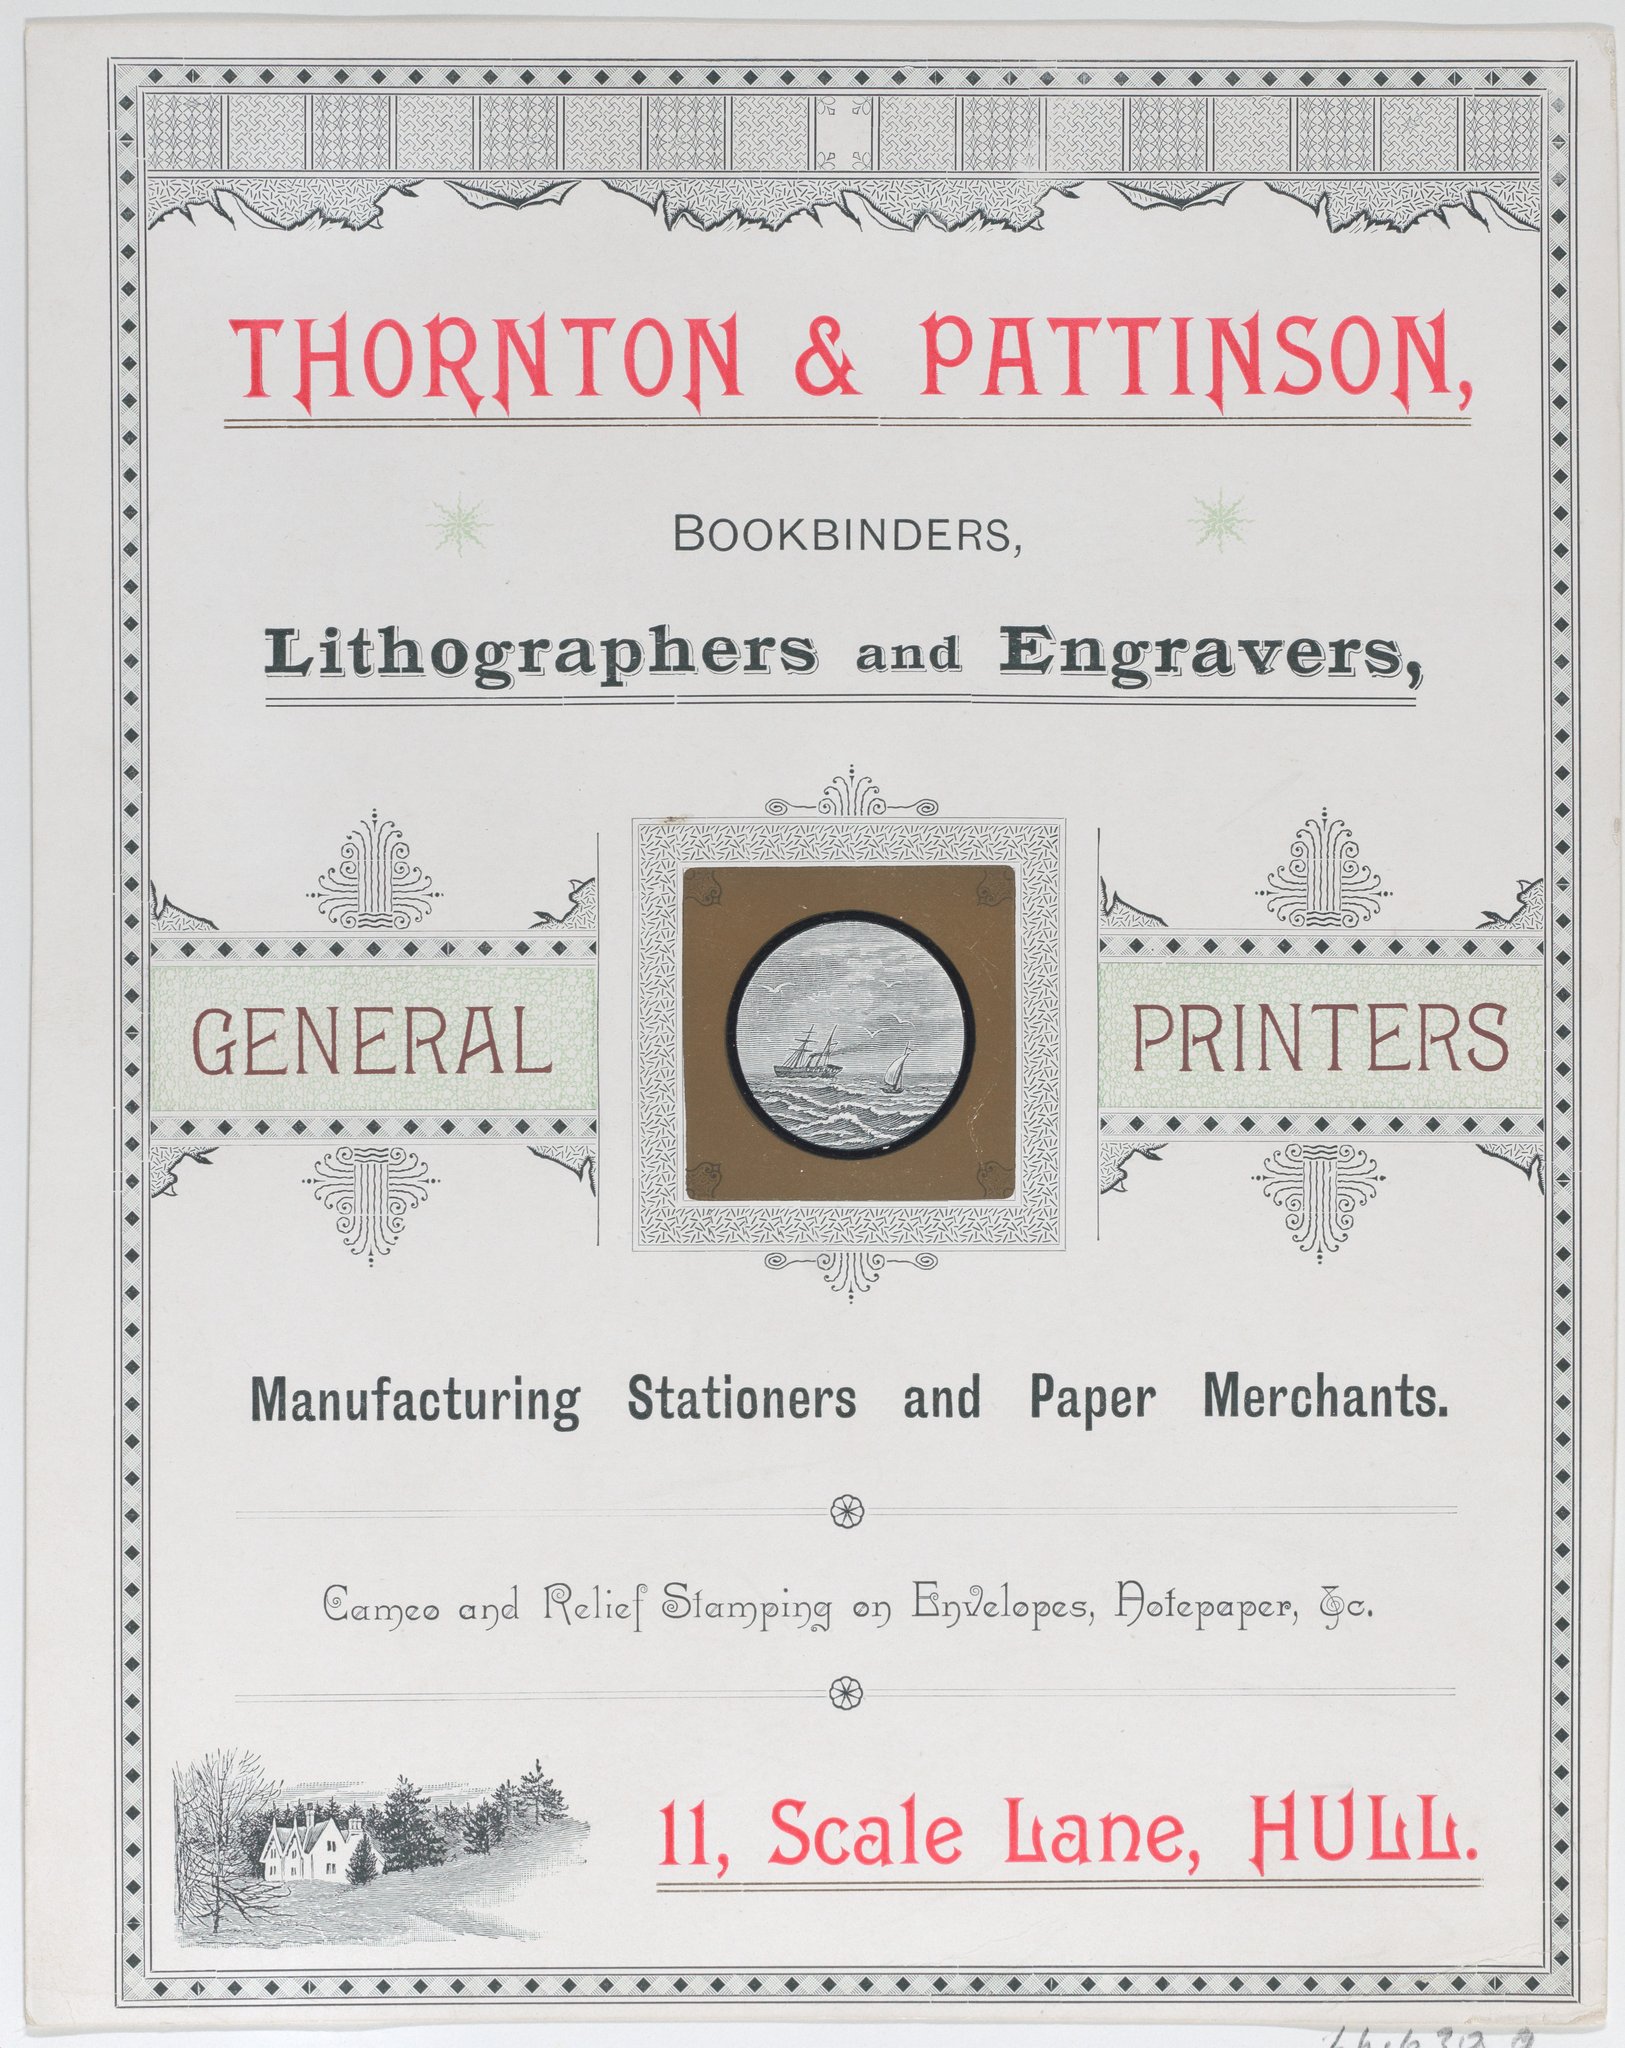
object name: print, trade card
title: Trade Card for Thorton & Pattinson, Bookbinders, Lithographers and Engravers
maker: anonymous, british, 19th century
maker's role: artist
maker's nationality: british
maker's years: 1800-1900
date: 1801-1900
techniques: lithography